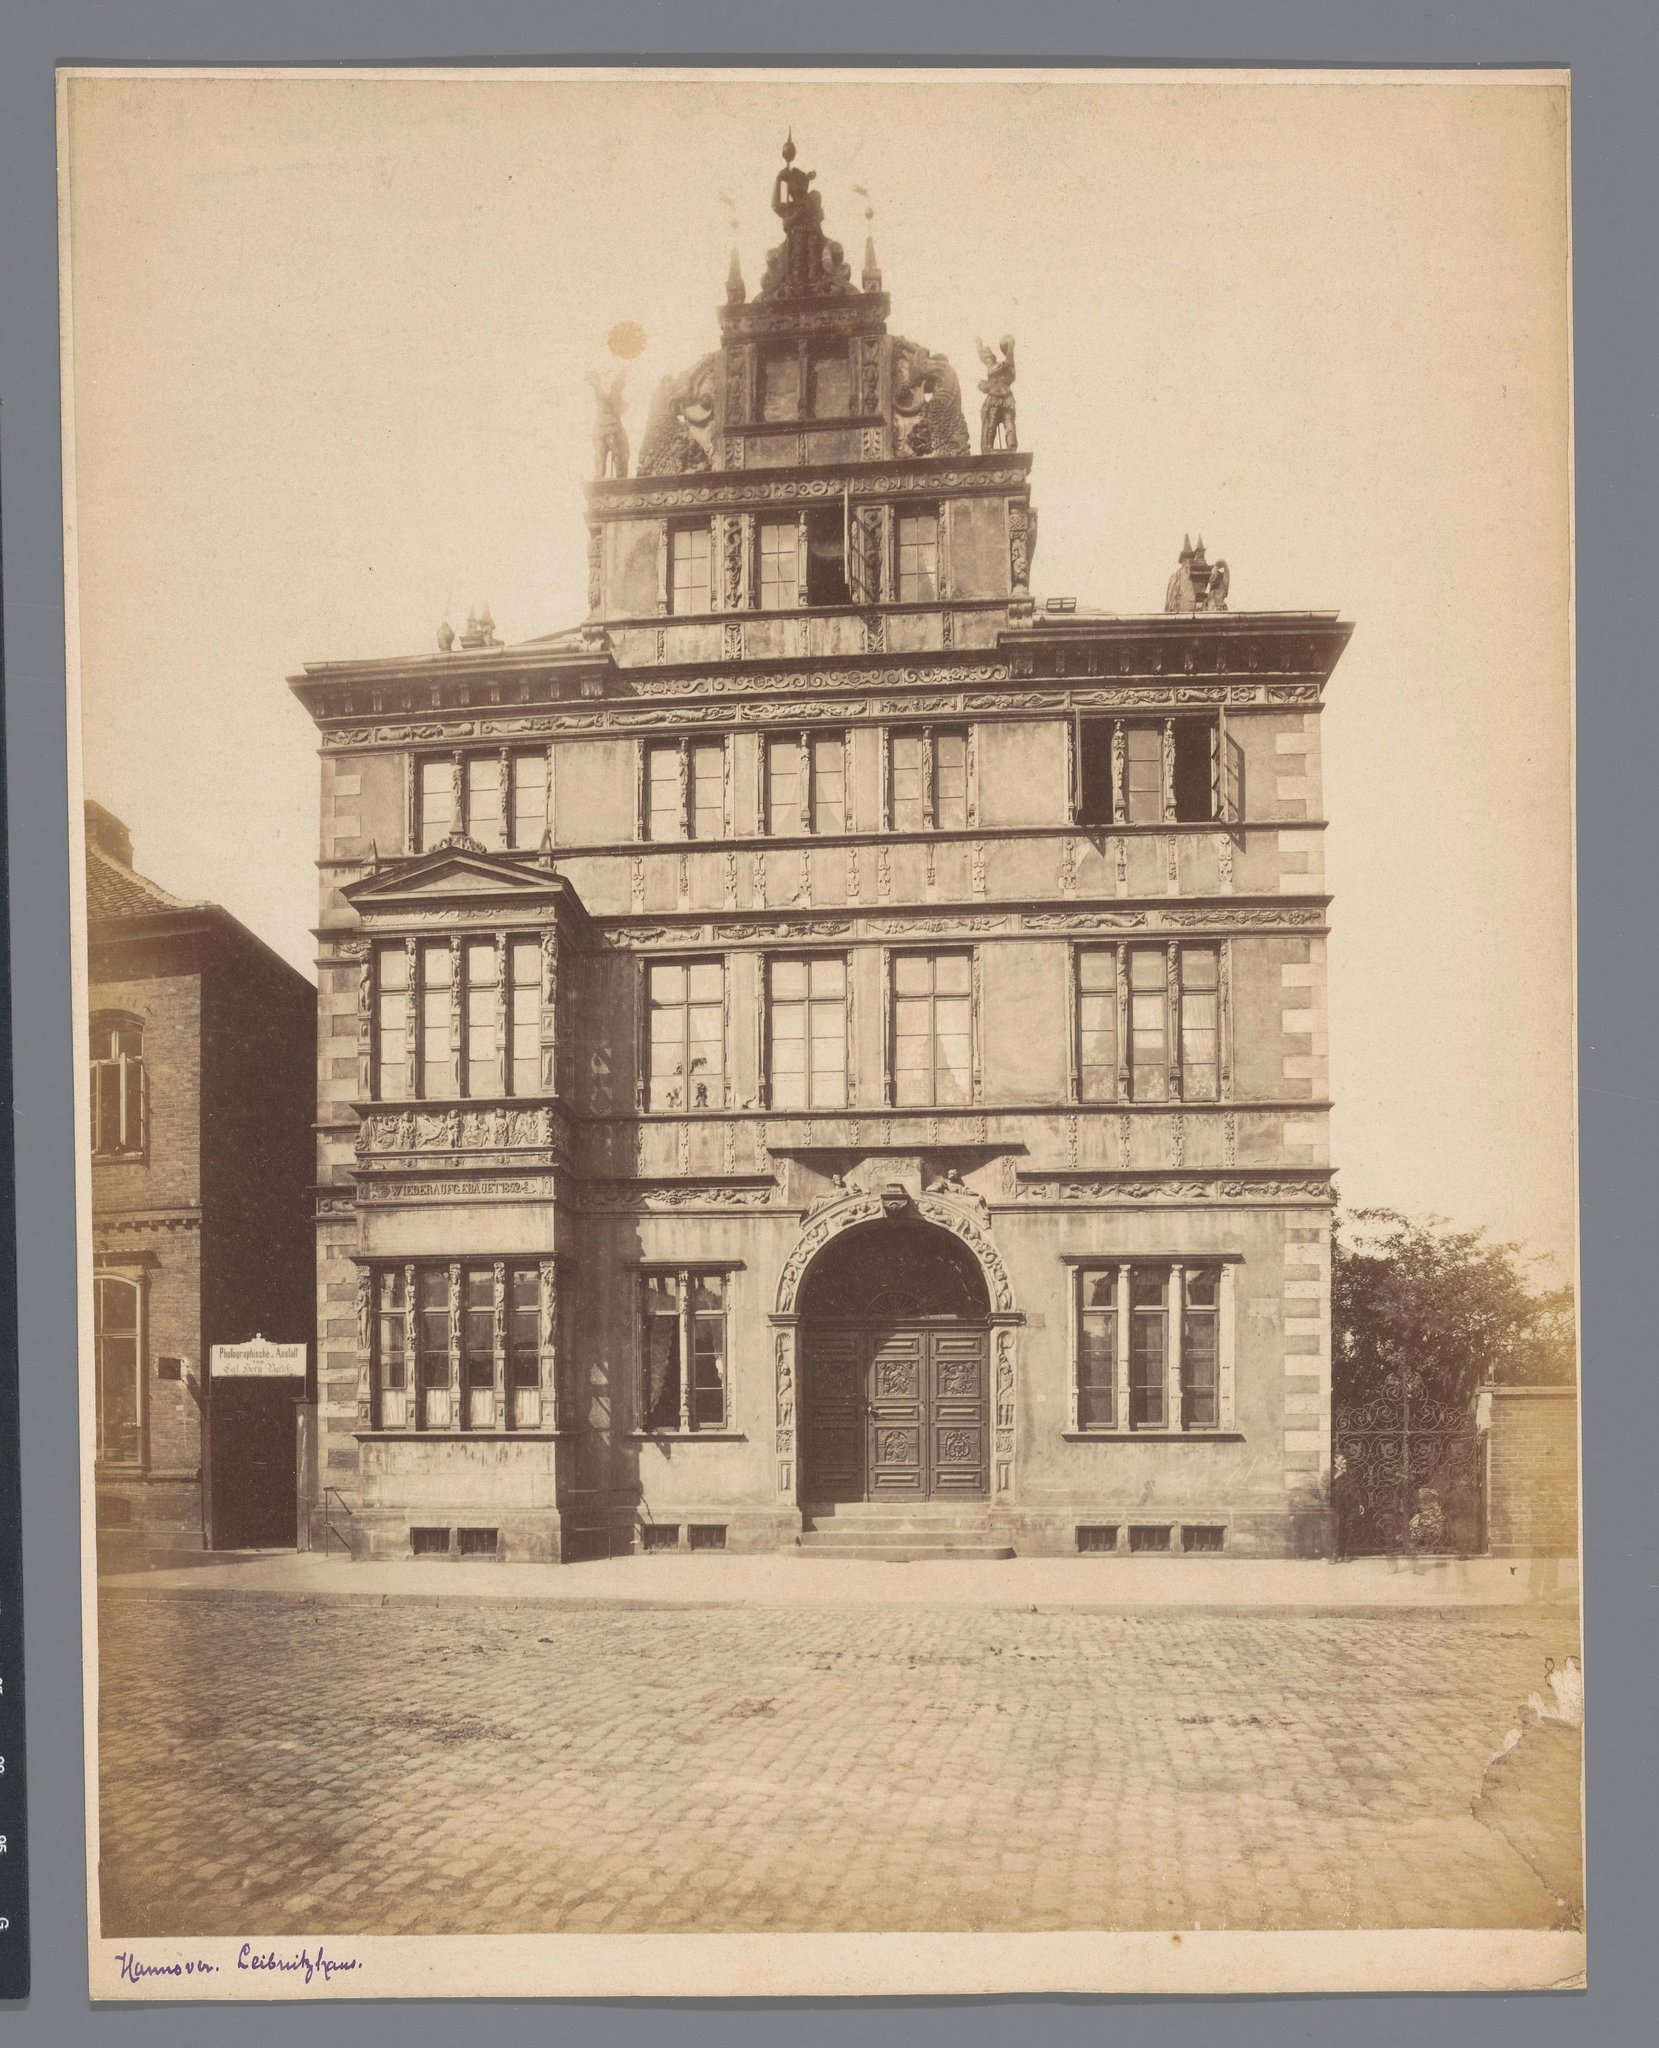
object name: photograph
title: Gebouw in Hannover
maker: Anonymous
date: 1868-1872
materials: cardboard, paper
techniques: albumen print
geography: hannover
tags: urban housing, façade (of house or building)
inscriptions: inscription: ‘Hannover. Leibnitzhaus’